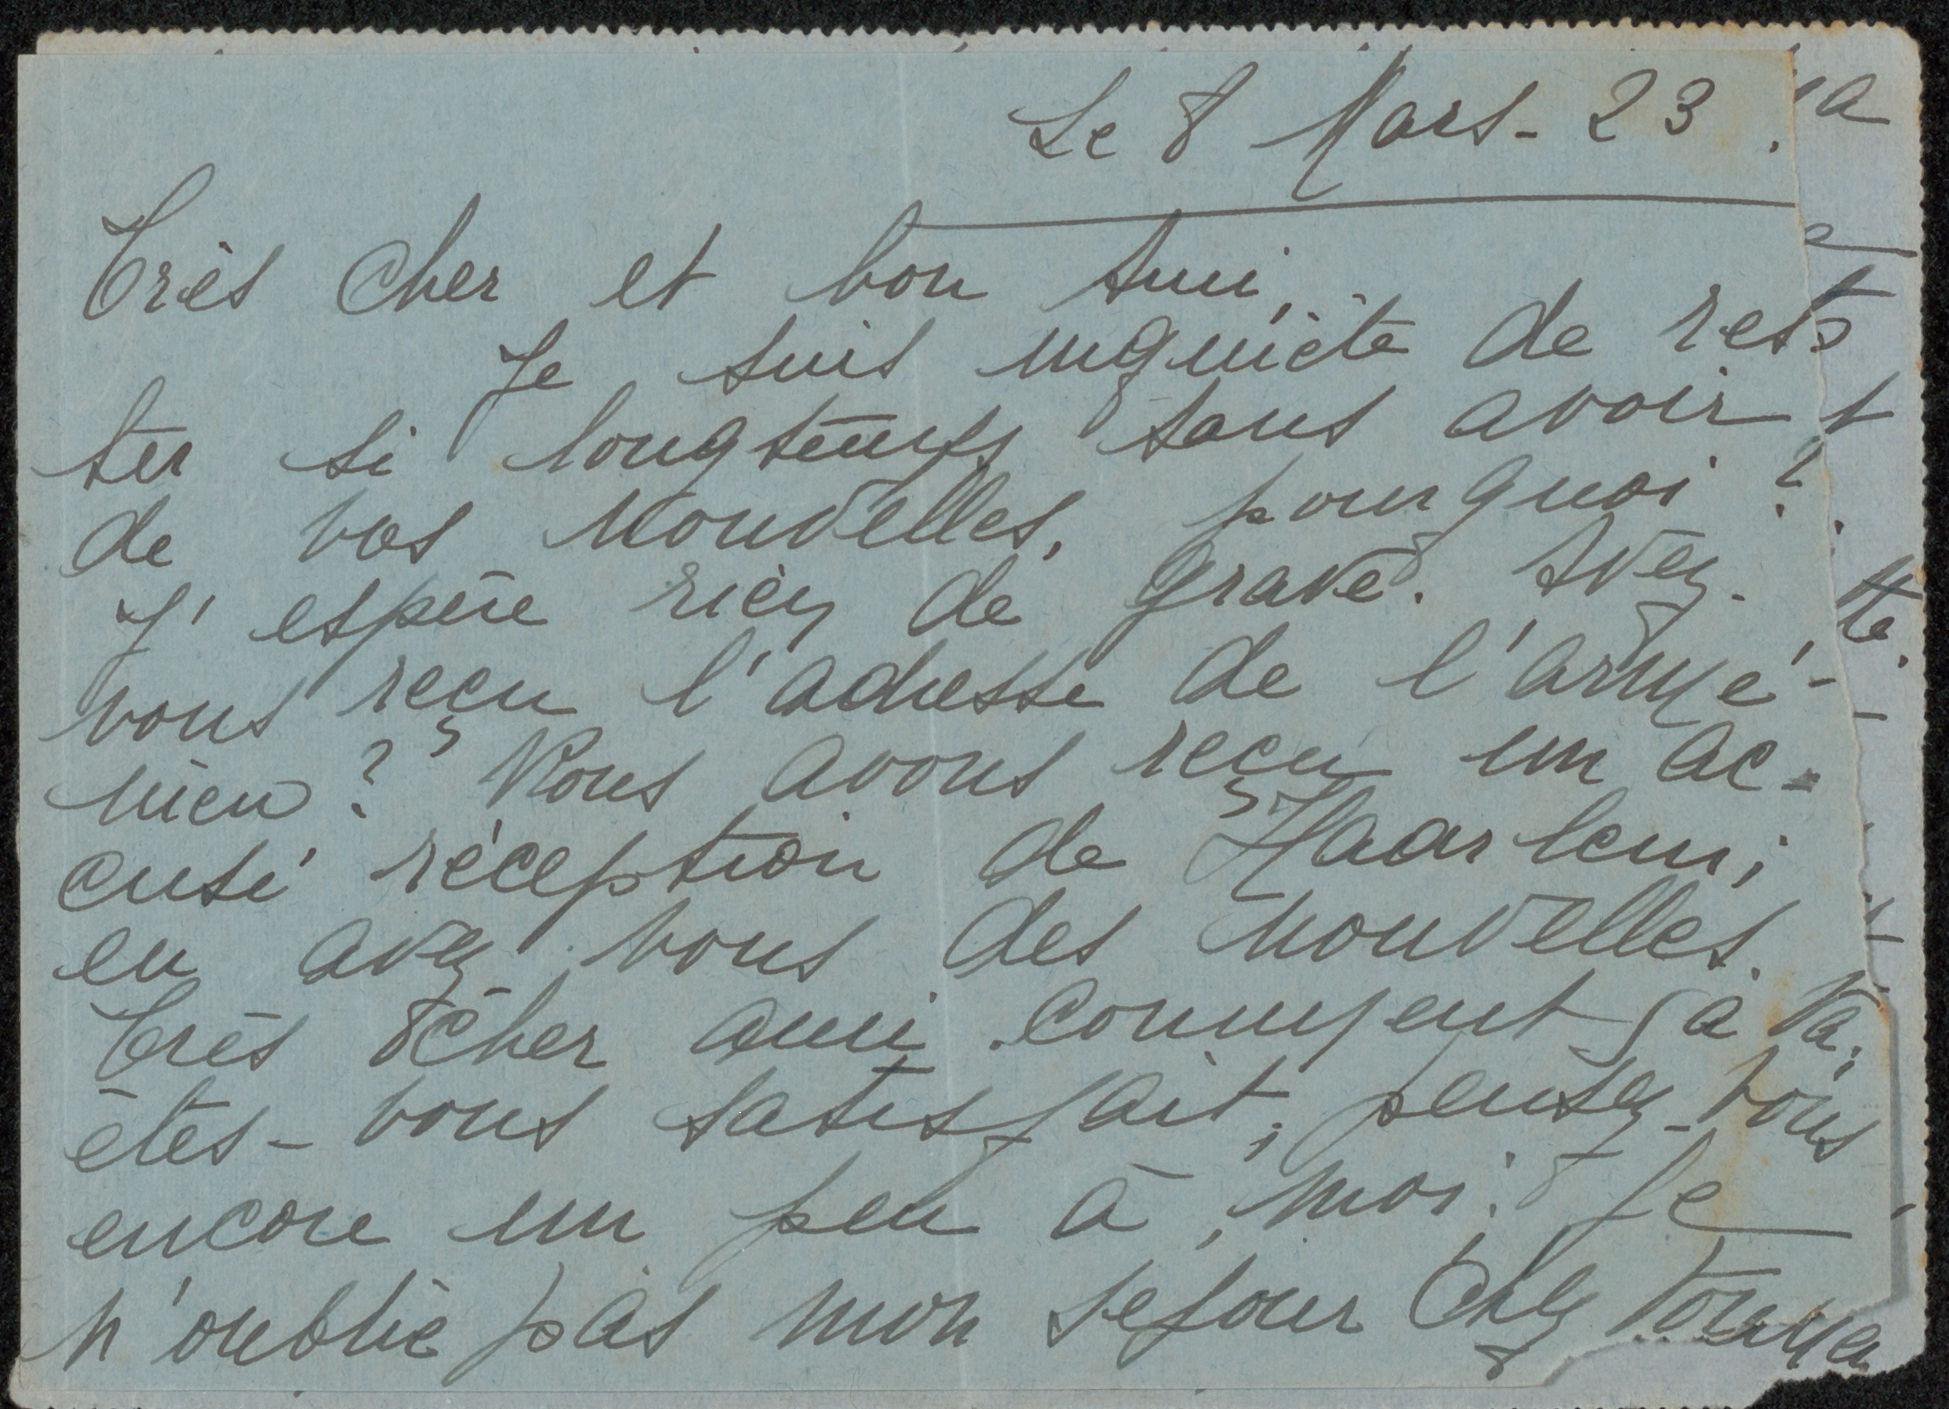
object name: letter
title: Brief aan Philip Zilcken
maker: rose imel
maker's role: draughtsman, painter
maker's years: 1901-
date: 1923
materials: ink, paper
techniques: pen, writing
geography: paris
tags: print maker, rosa bonheur, painter, draughtsman, philip zilcken, exhibition ~ art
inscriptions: collector's mark: ‘RPK’